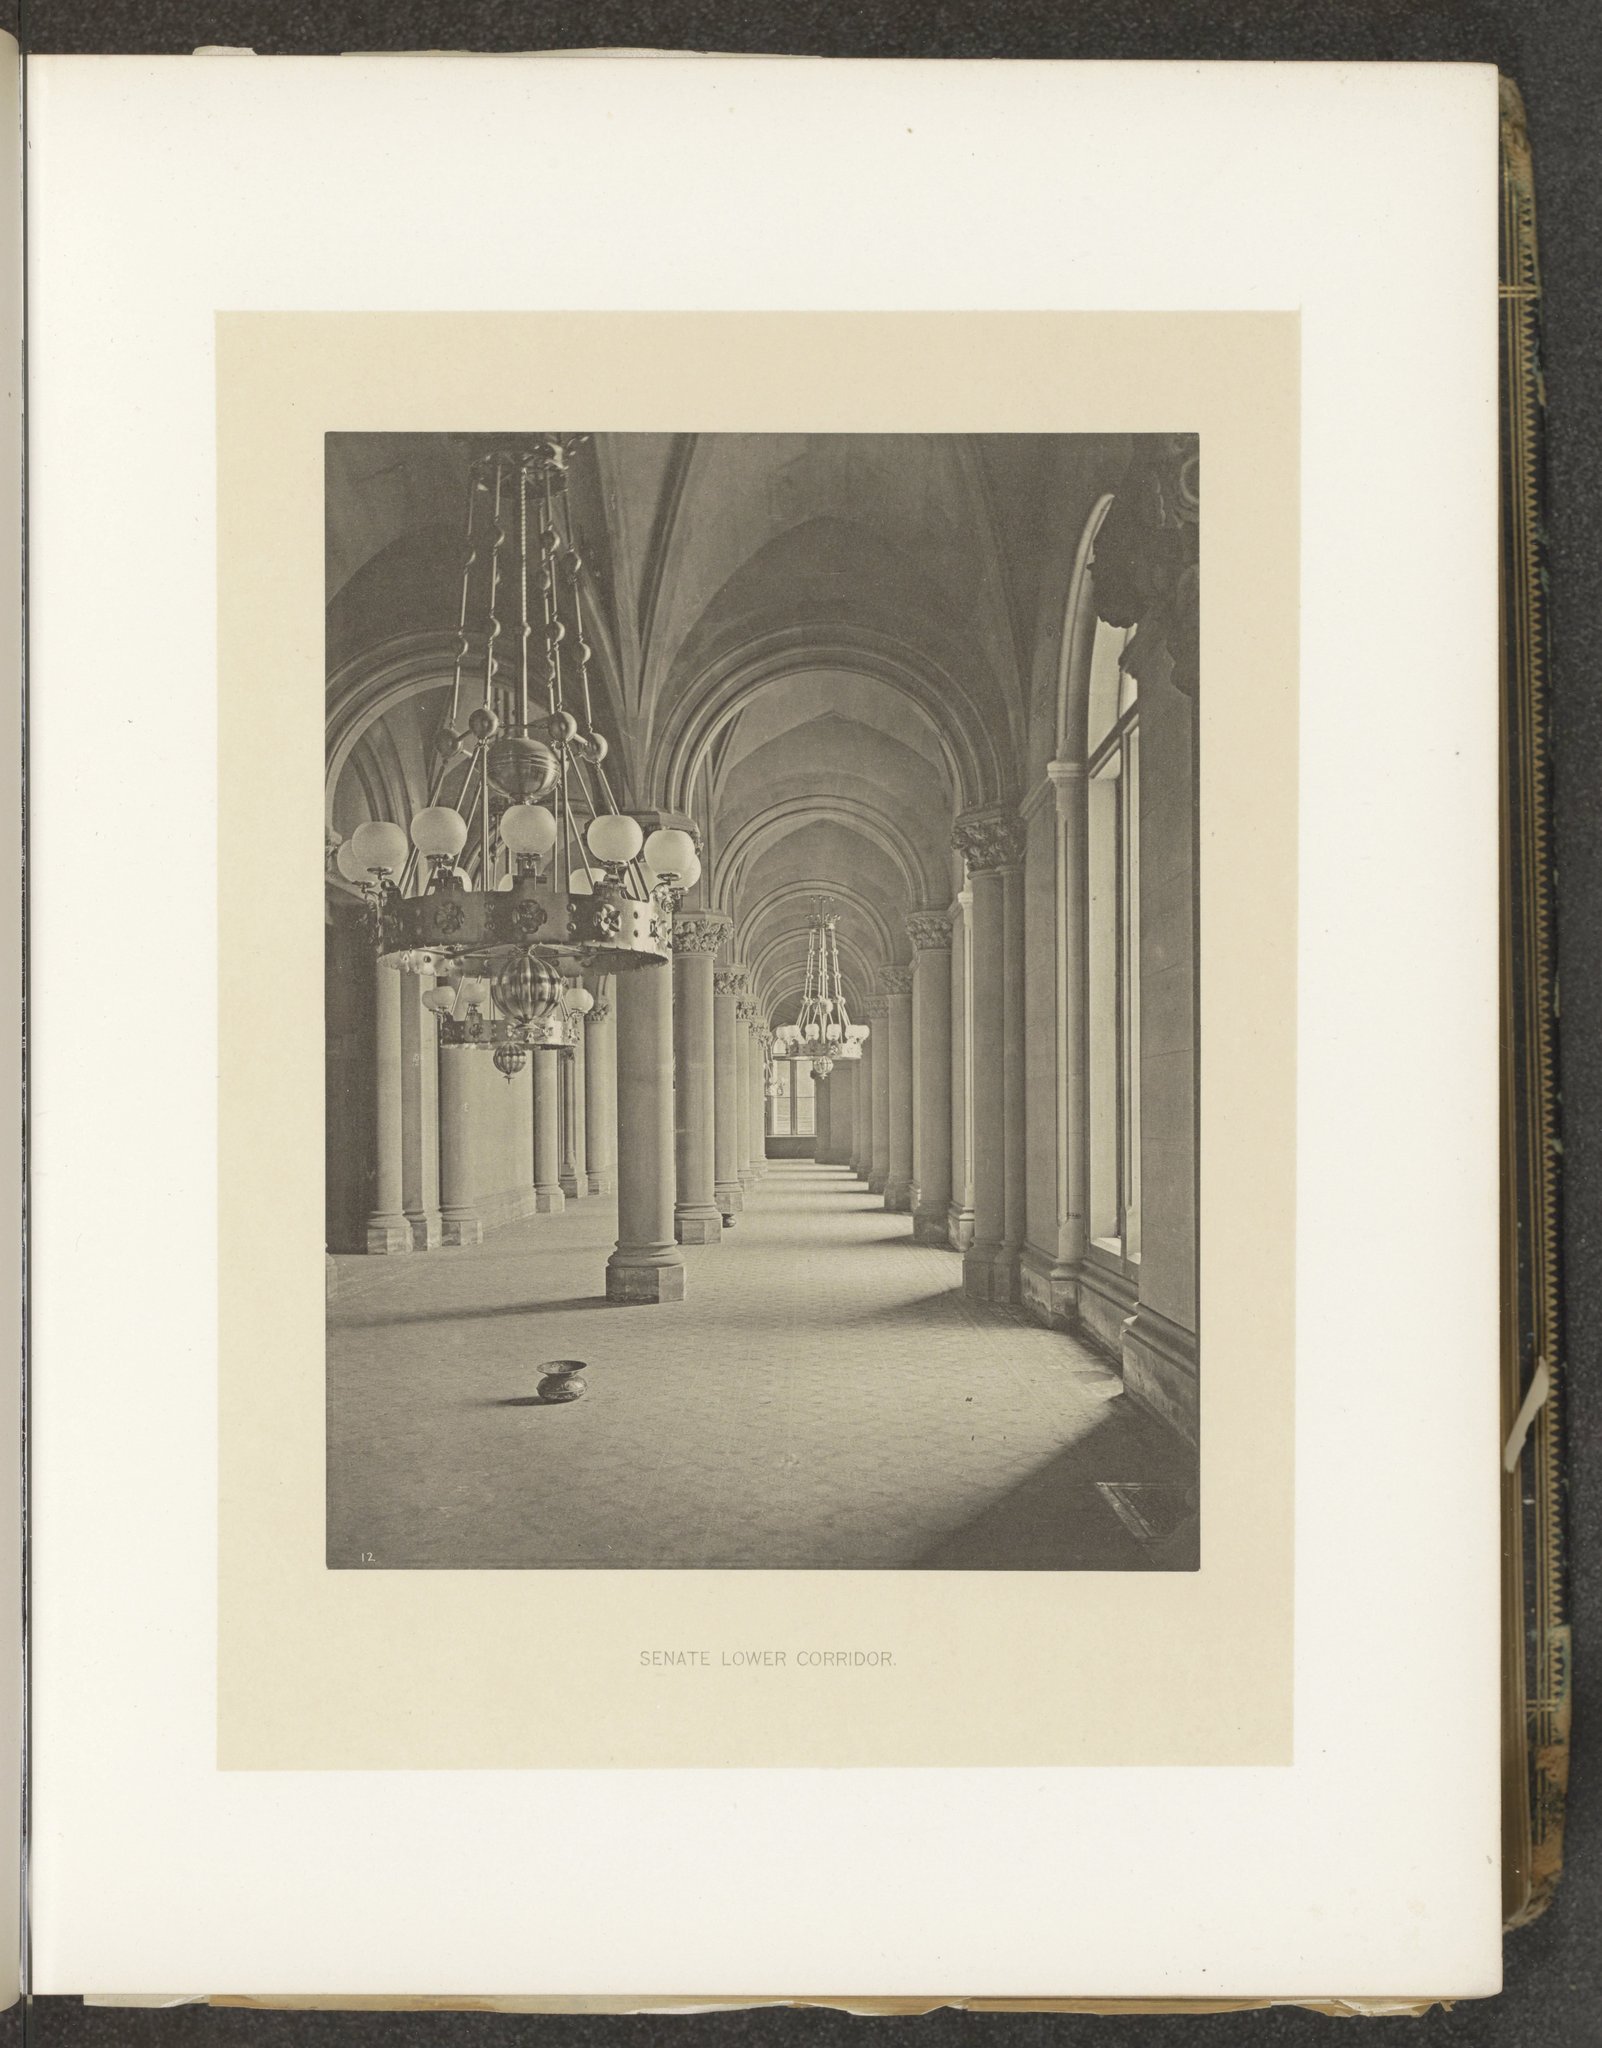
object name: page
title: Senate lower corridor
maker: Anonymous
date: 1879-1882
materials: paper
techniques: photograph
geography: united states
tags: corridor, interior ~ representation of a building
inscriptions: number: ‘12’